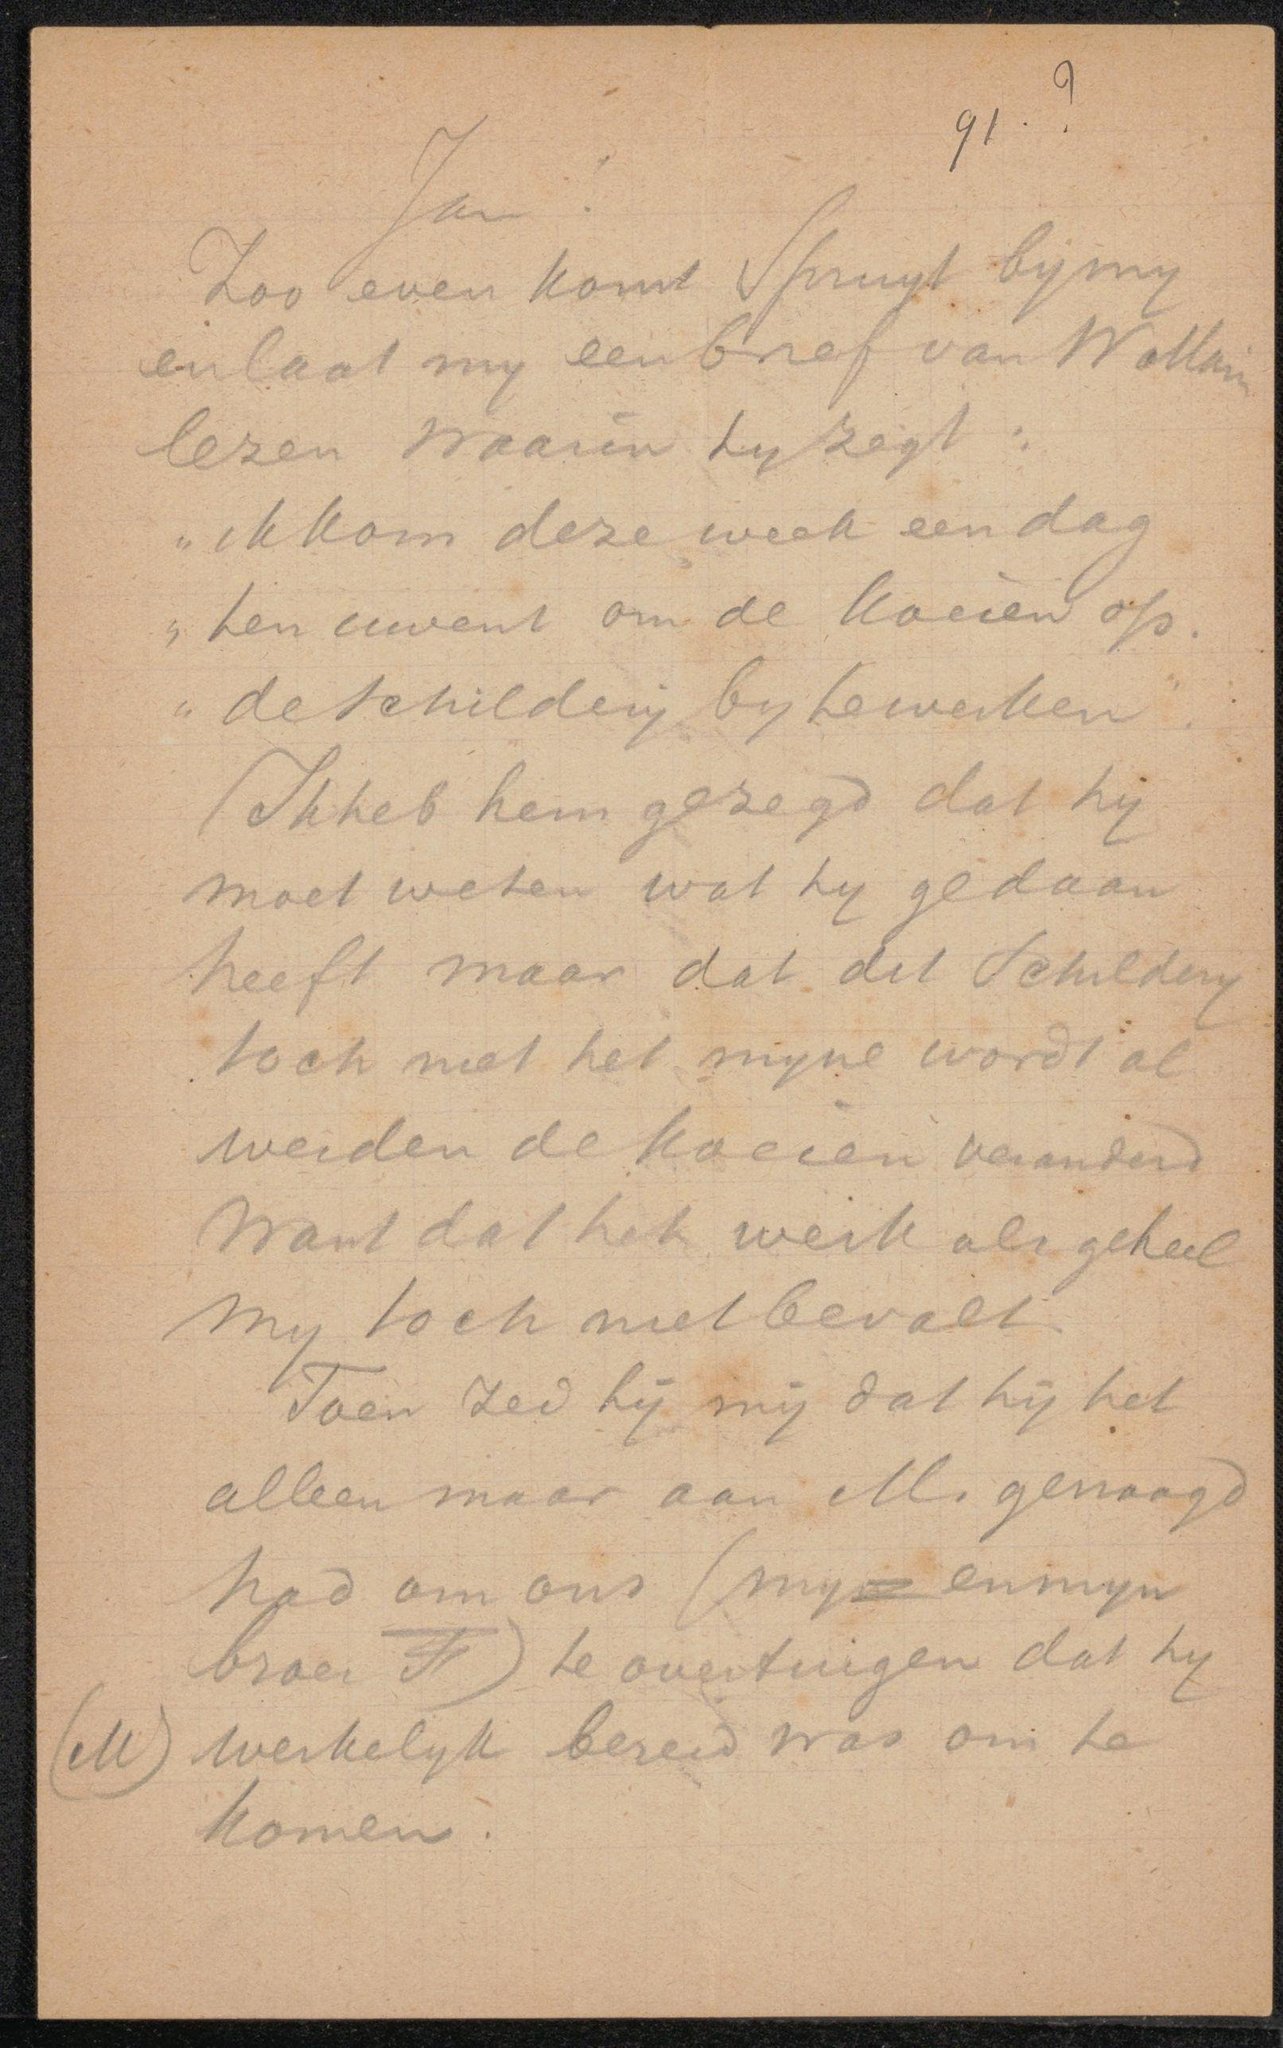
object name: letter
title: Brief aan Jan Veth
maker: martinus cornelis lebret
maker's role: verzamelaar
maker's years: 1833-1894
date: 1874-1894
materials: pencil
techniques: pen, writing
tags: painter, print maker, draughtsman, jan veth, willem maris, painting (including book-illumination, miniature-painting)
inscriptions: collector's mark: ‘RPK’